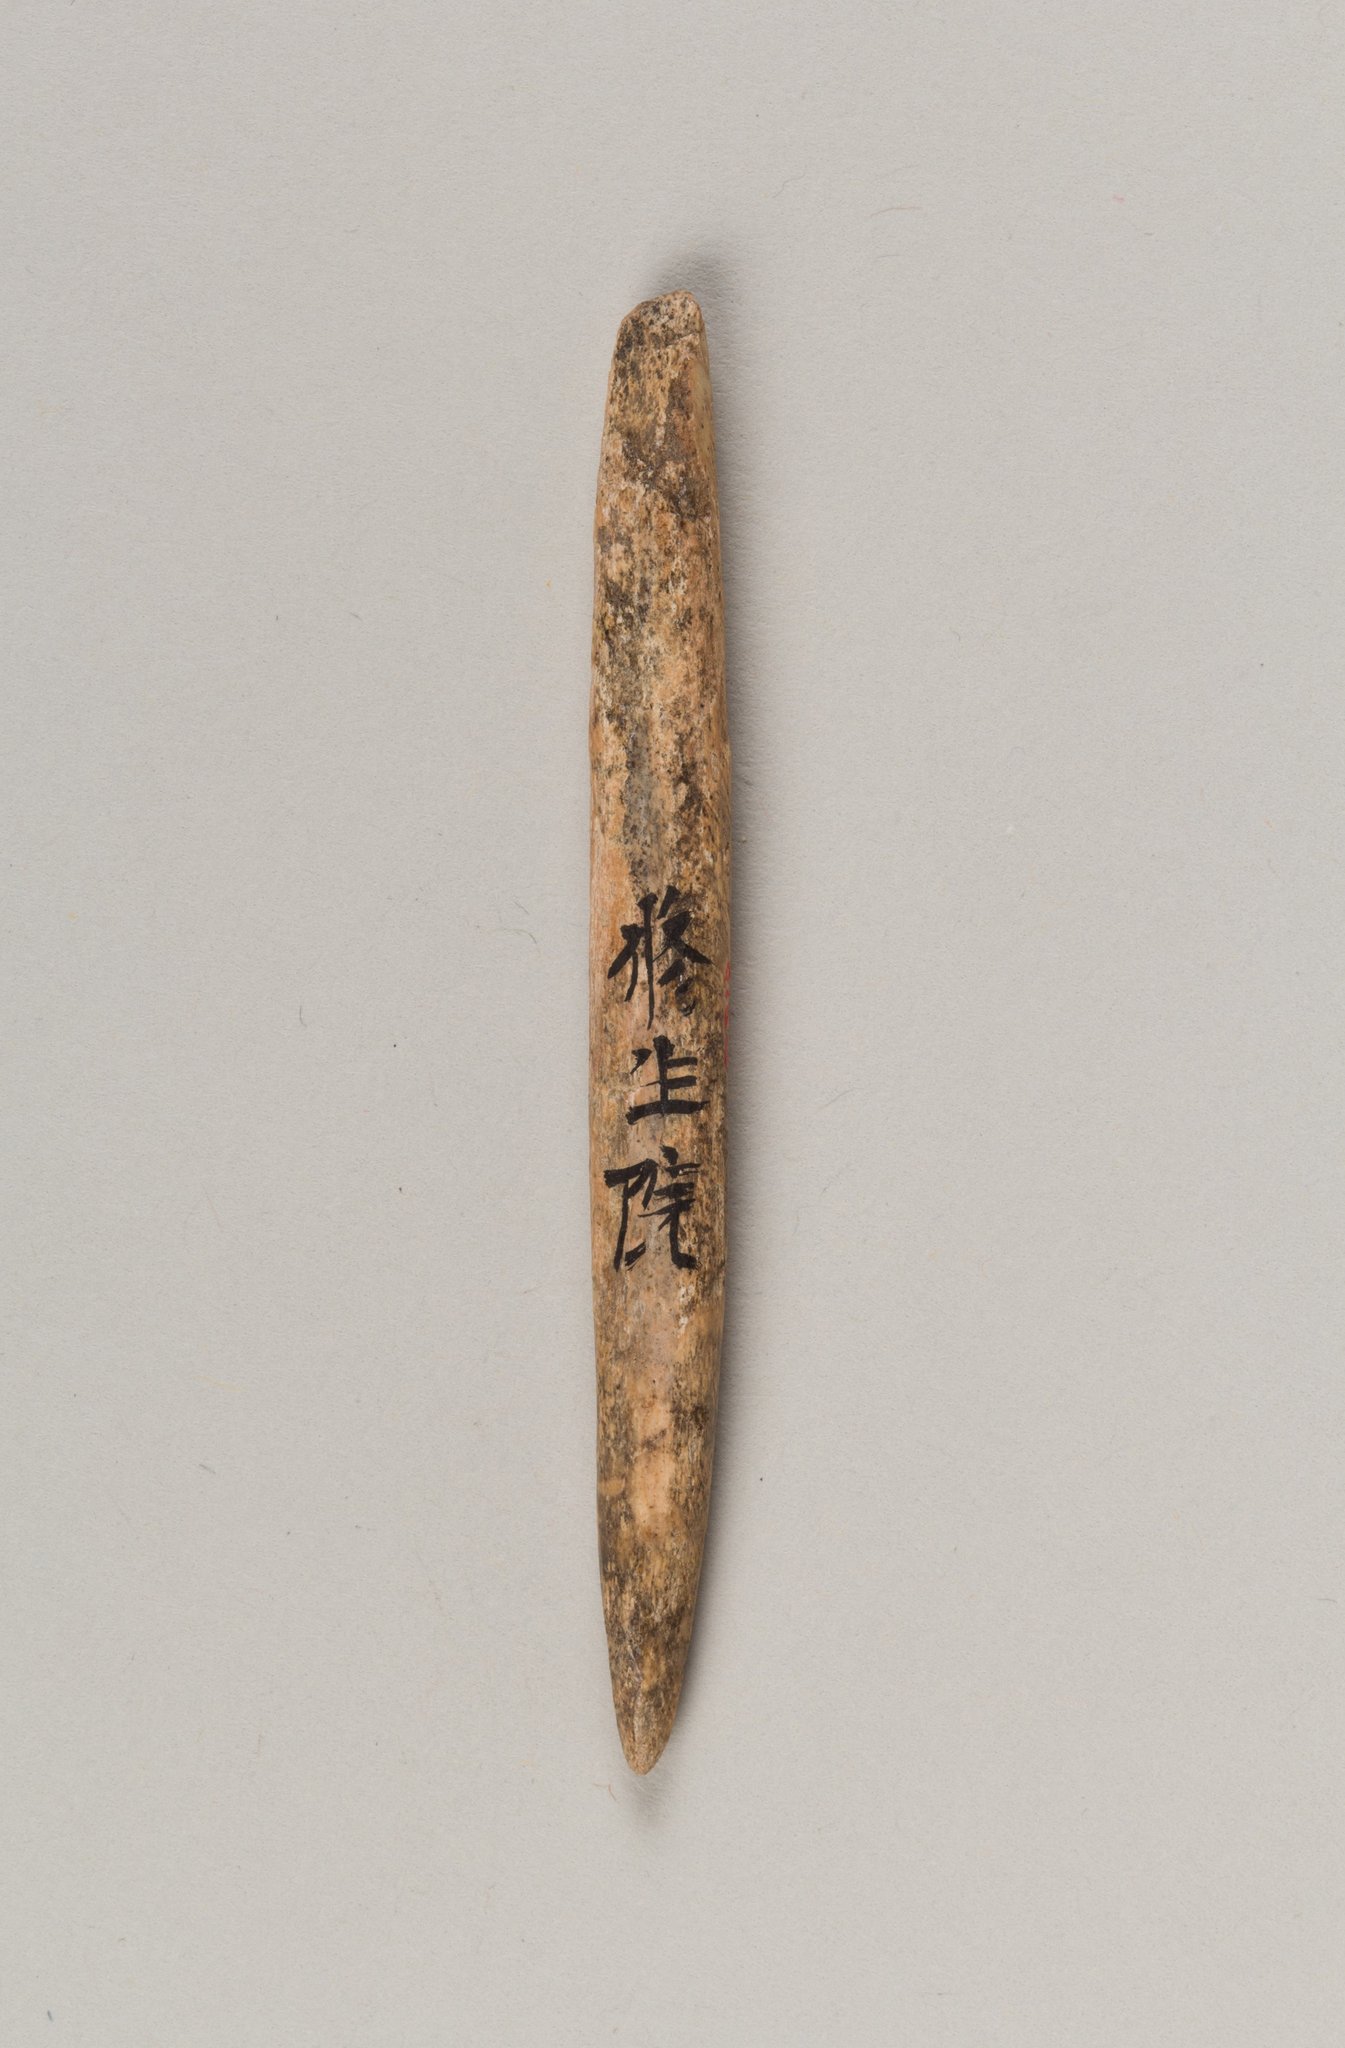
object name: harpoon head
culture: japanese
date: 1000-300 BCE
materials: bone